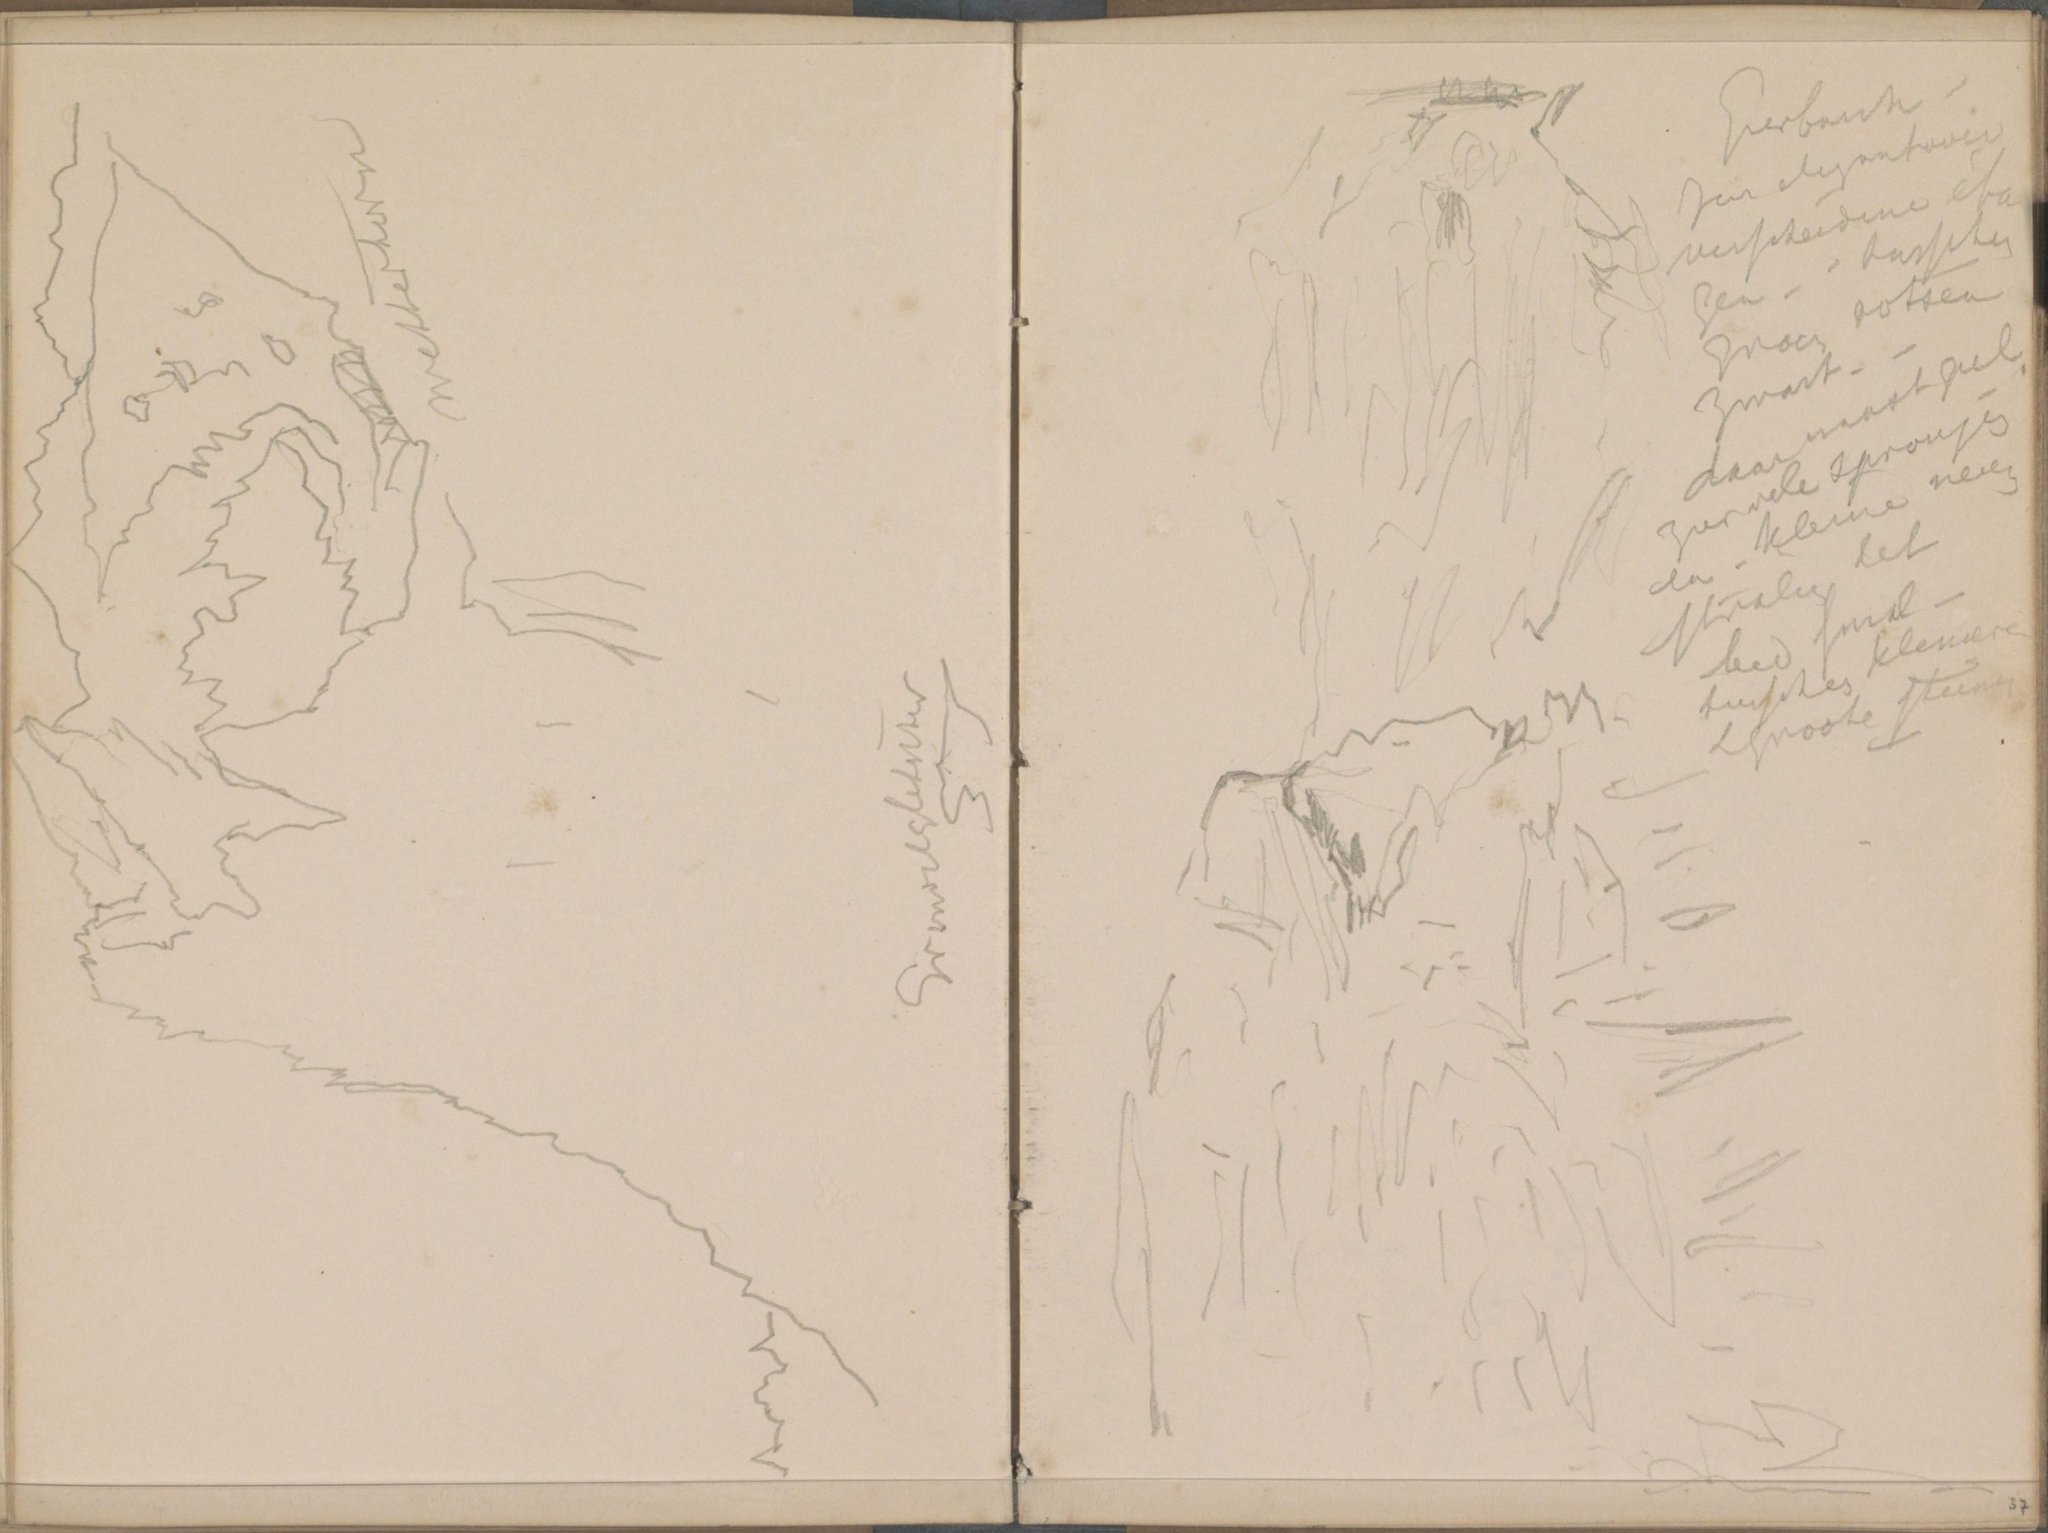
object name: sketchbook leaf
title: Matterhorn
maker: johannes tavenraat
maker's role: draughtsman, painter, print maker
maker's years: 1809-1881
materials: paper, pencil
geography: alps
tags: mountain-range, snow peaks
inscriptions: annotation: ‘metterhorn/ gron[...]gletscher’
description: Blad 36 verso uit een schetsboek met 47 bladen.